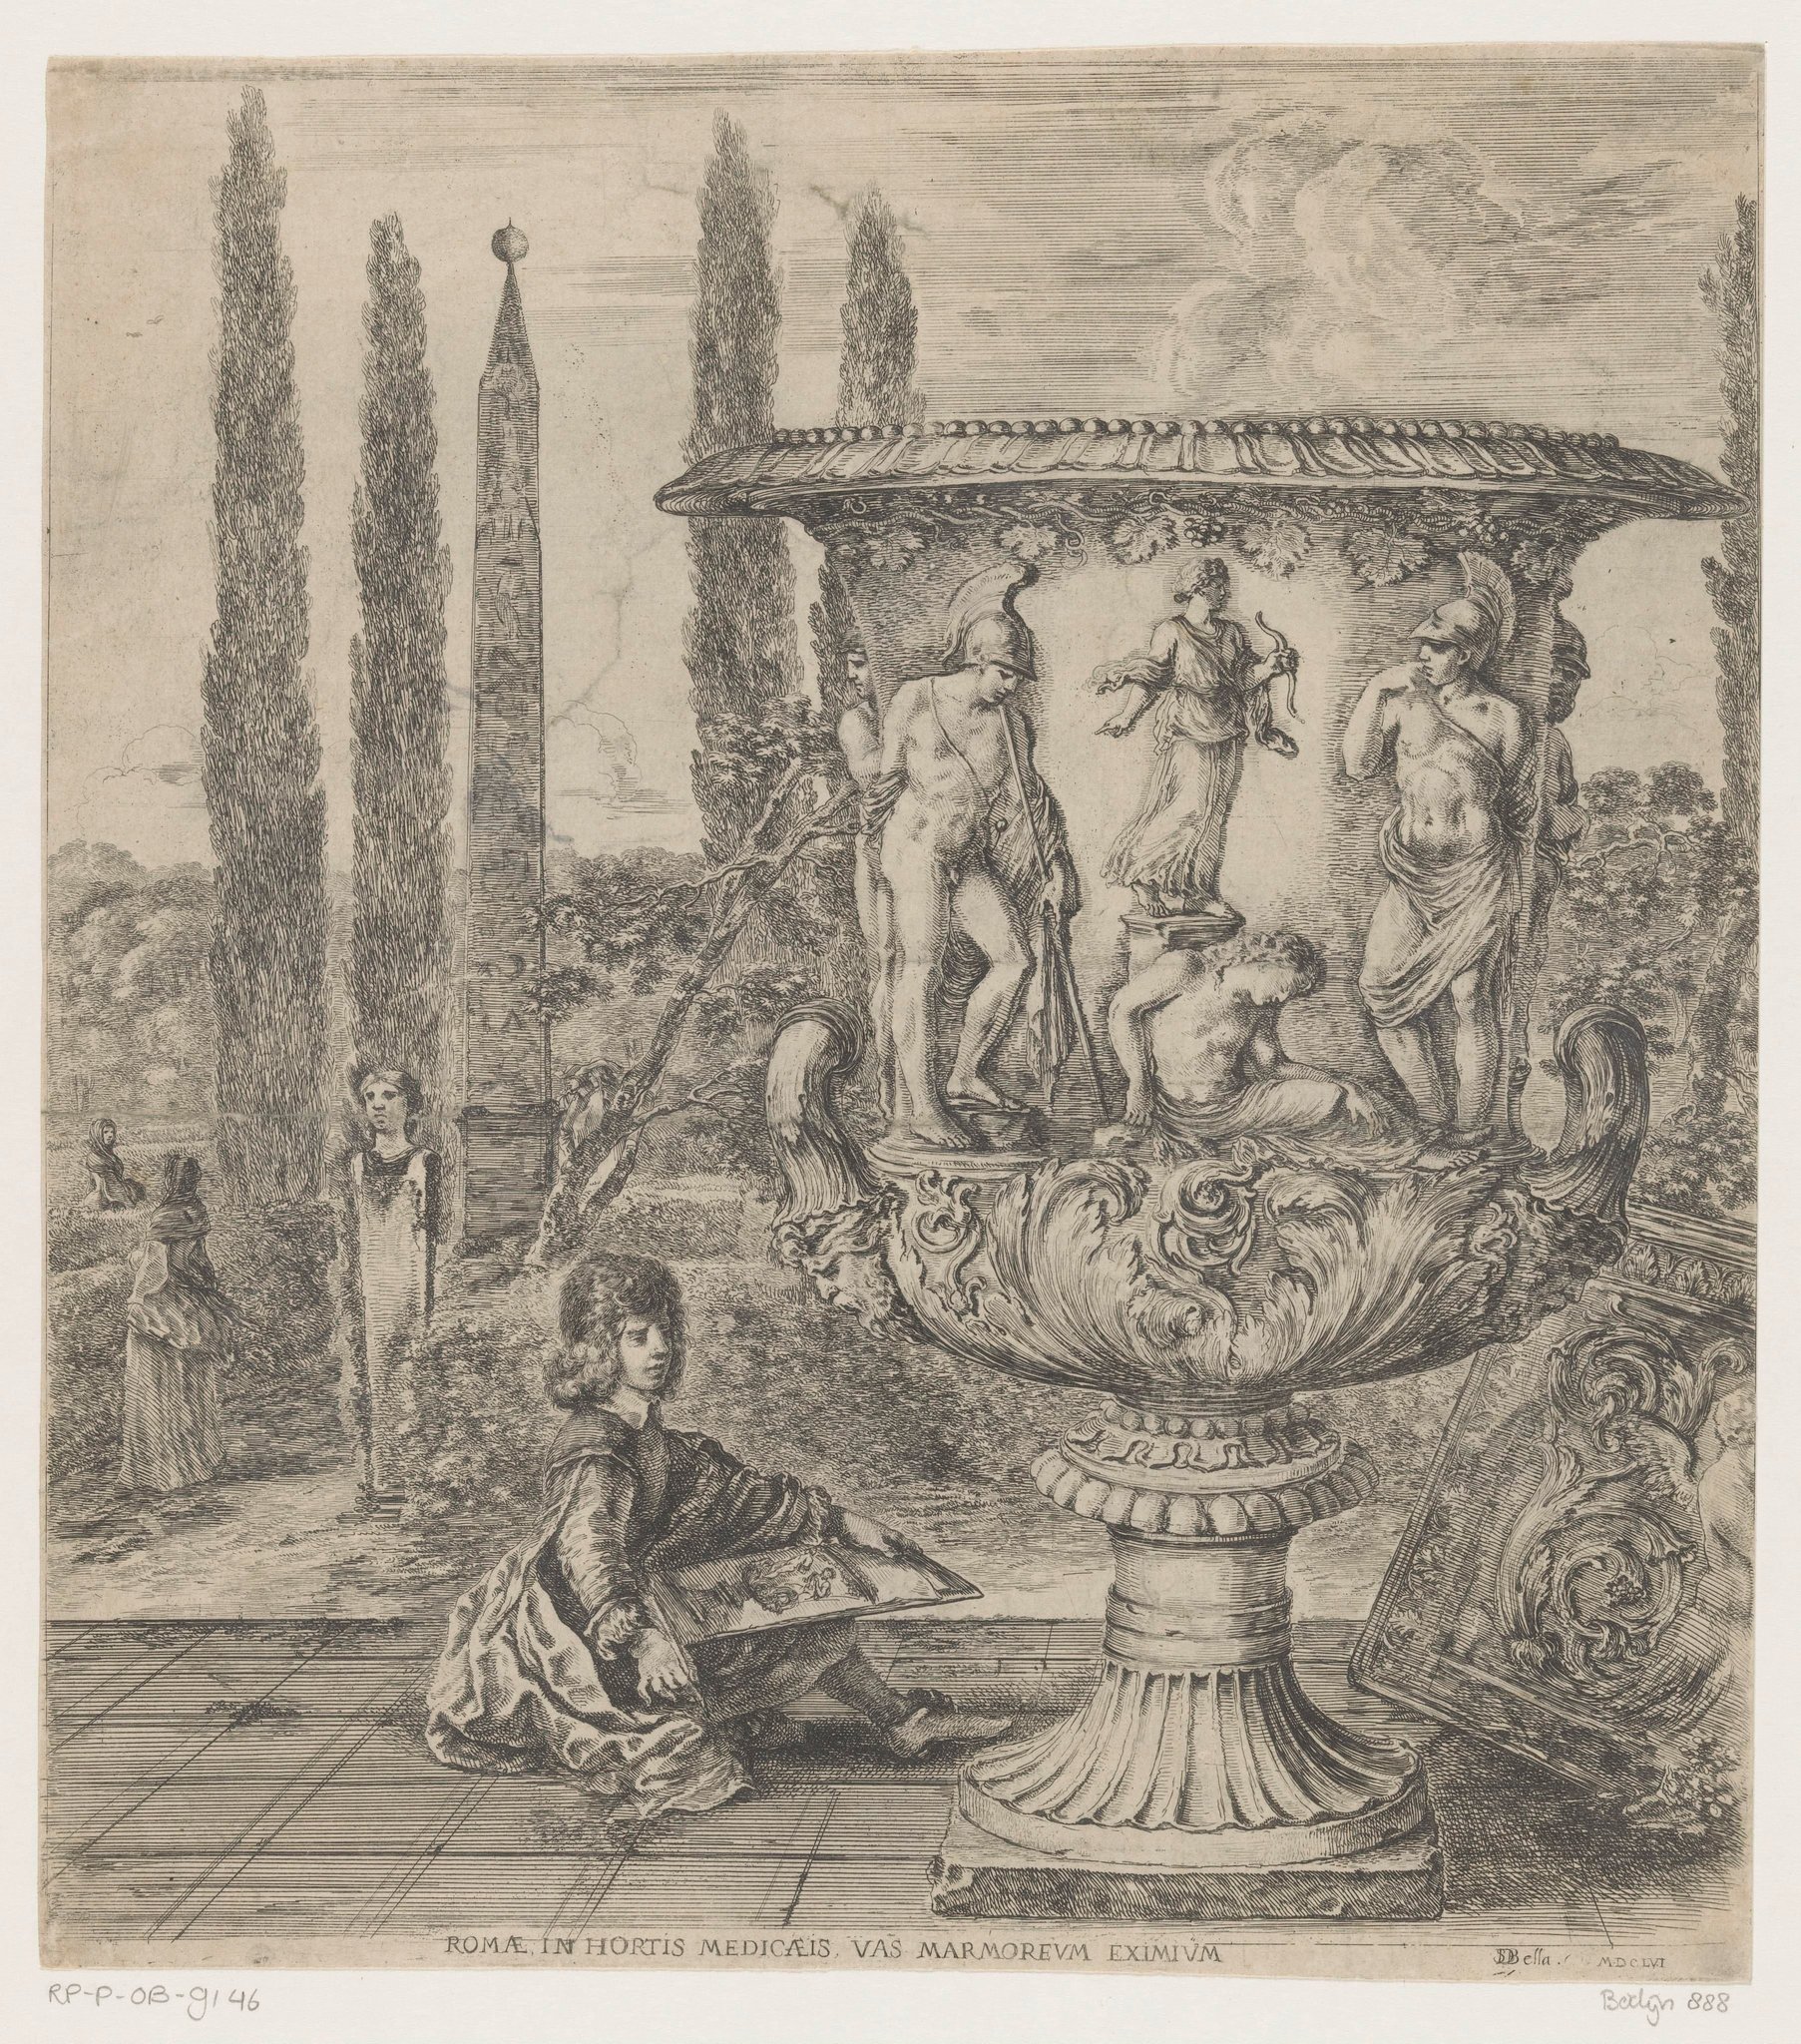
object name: ornament print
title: Gezichten op Rome en omgeving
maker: stefano della bella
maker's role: draughtsman, print maker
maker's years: 1610-1664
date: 1656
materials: paper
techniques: etching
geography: italy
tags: cosimo iii de' medici, garden, draughtsman studying classical remains - cc - out of doors, garden vase, rome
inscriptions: collector's mark: Lugt 2228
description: Zicht in de tuin van de Villa Medici te Rome. De jonge Cosimo III de Medici zit de Medici-vaas (een grote gedecoreerde marmeren krater uit de oudheid) na te tekenen. Op de achtergrond een obelisk.